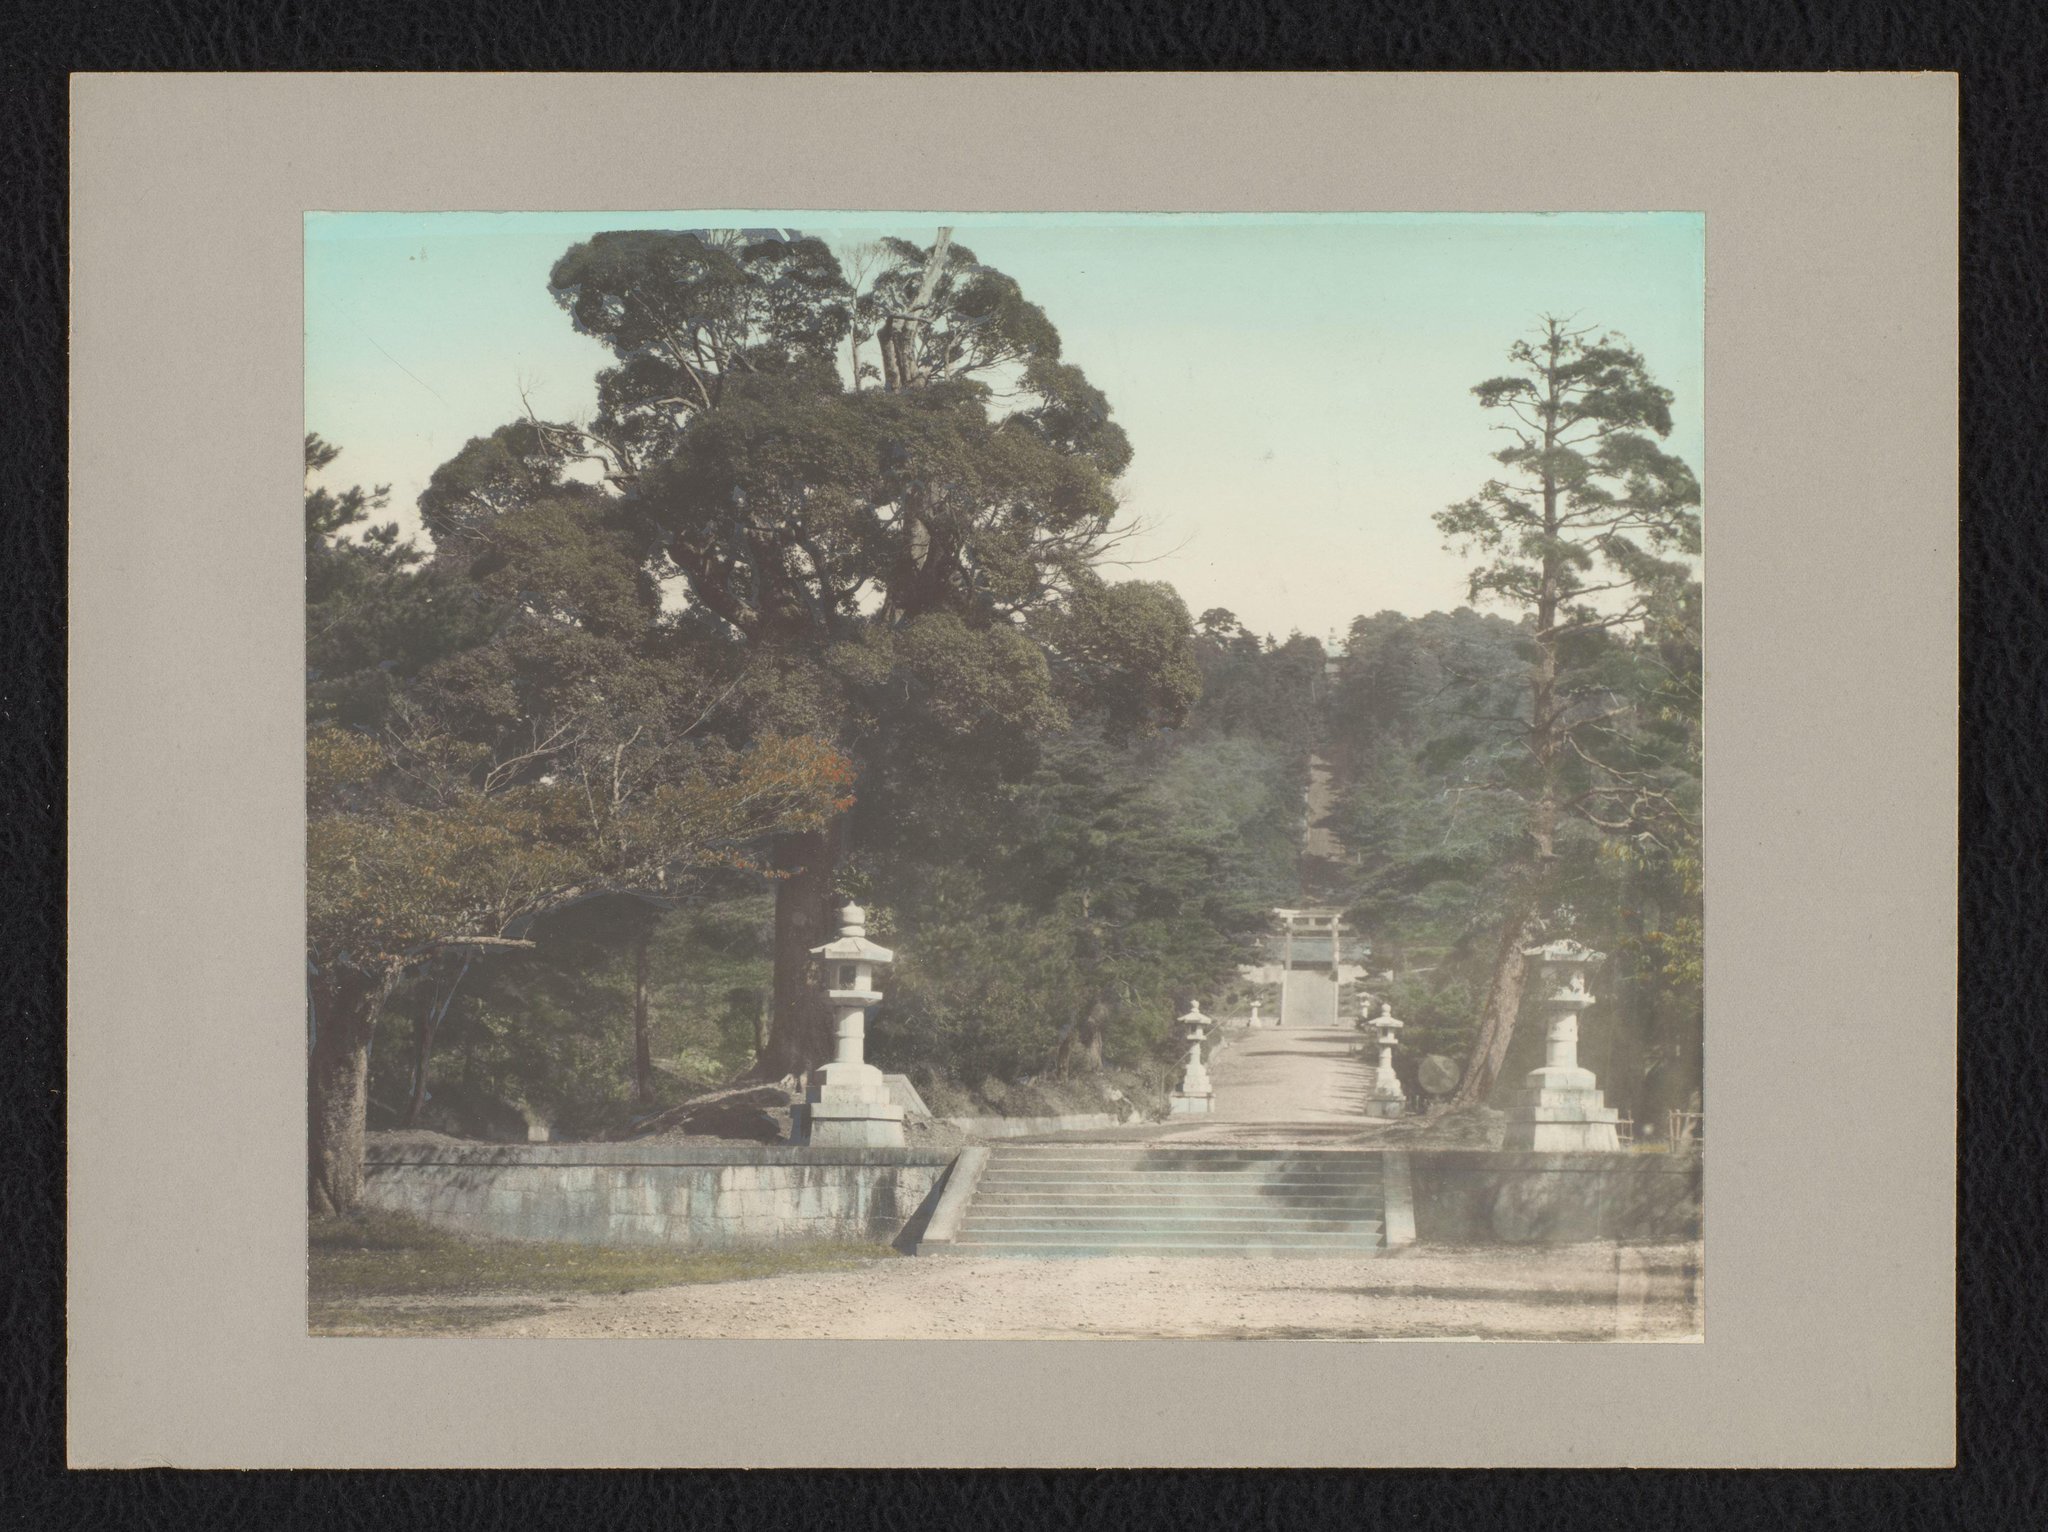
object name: photograph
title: Trap tussen bomen, Kyoto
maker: Anonymous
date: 1895-1915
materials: cardboard, photographic support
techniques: gelatin silver print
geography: kyoto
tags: kyoto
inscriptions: annotation: ‘5. Kioto’